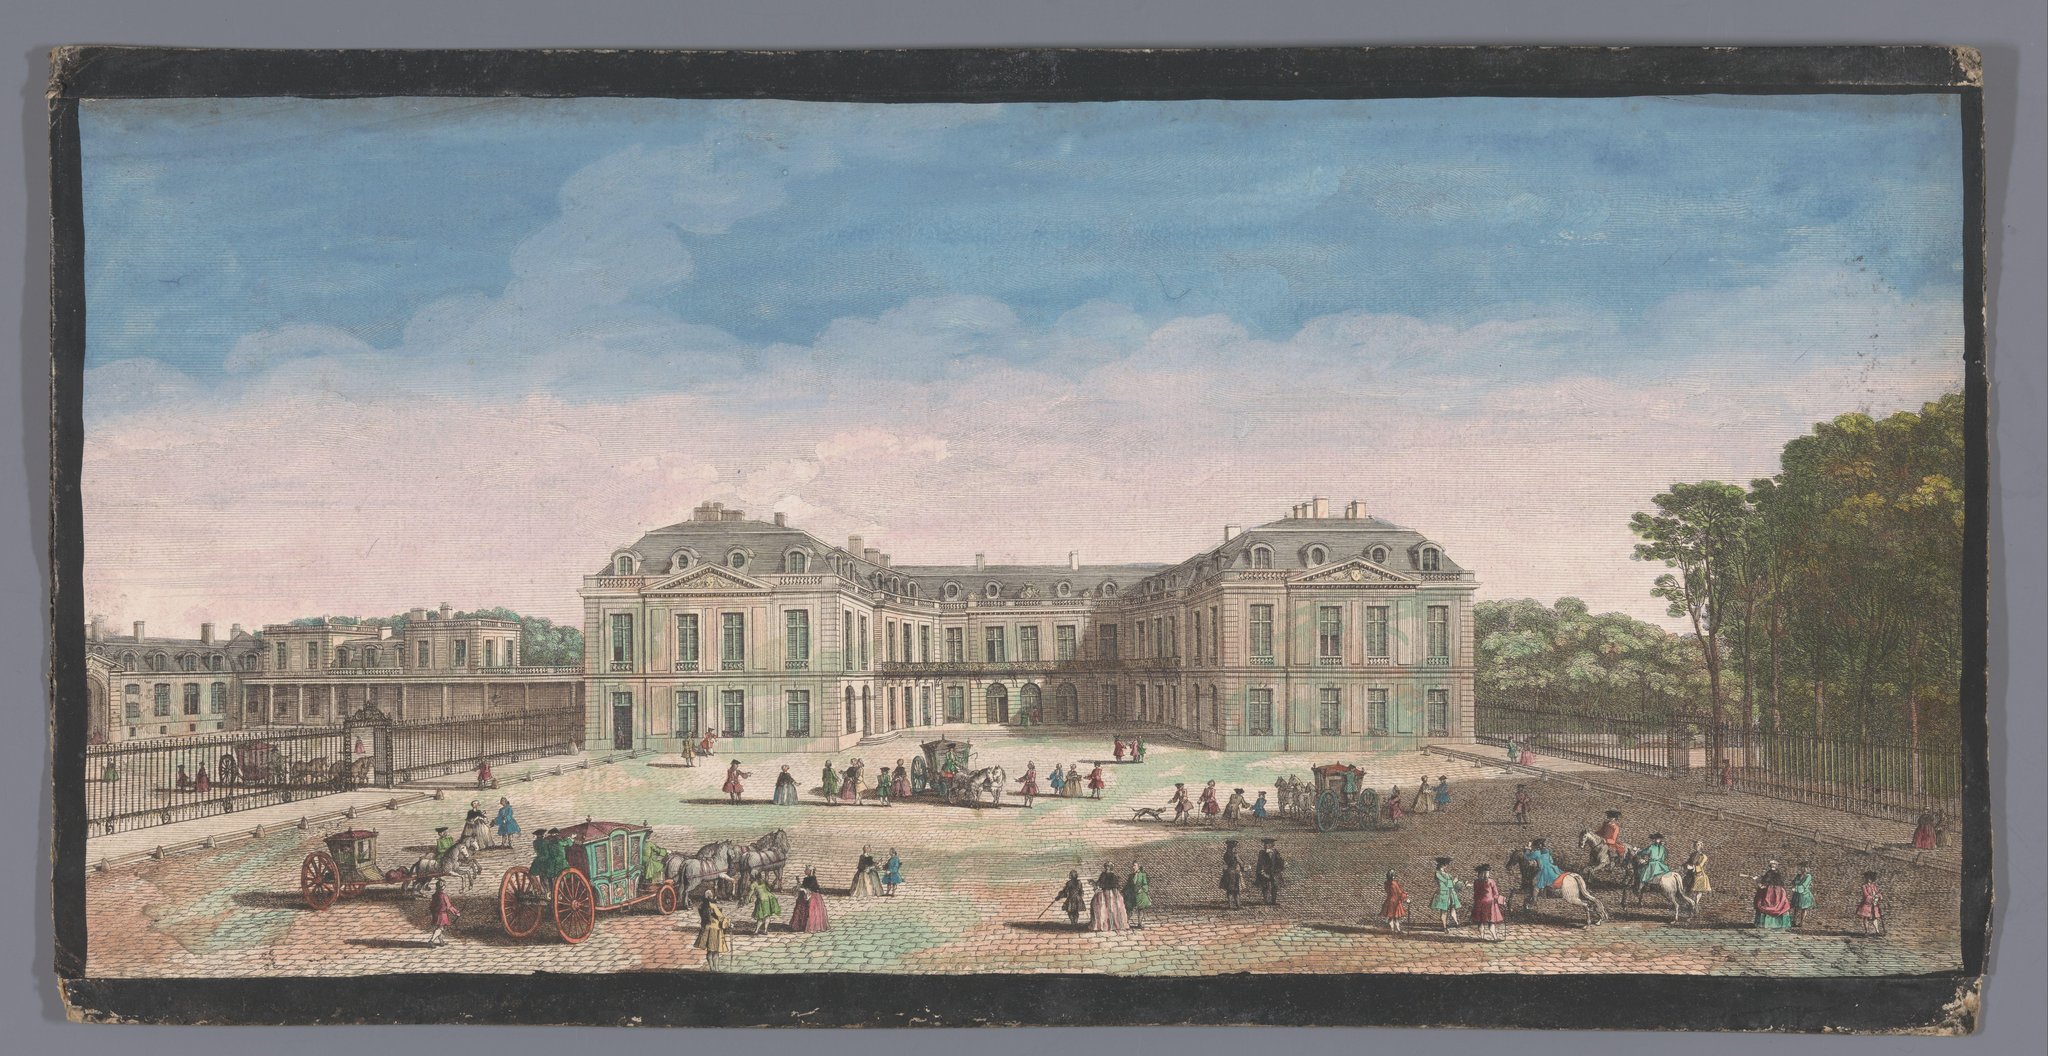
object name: opticaprent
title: Gezicht op het Château de Choisy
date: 1700-1799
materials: cardboard, paper, watercolor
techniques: brush, etching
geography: paris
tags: civic architecture; edifices; dwellings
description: In de ondermarge een regel Franse tekst.